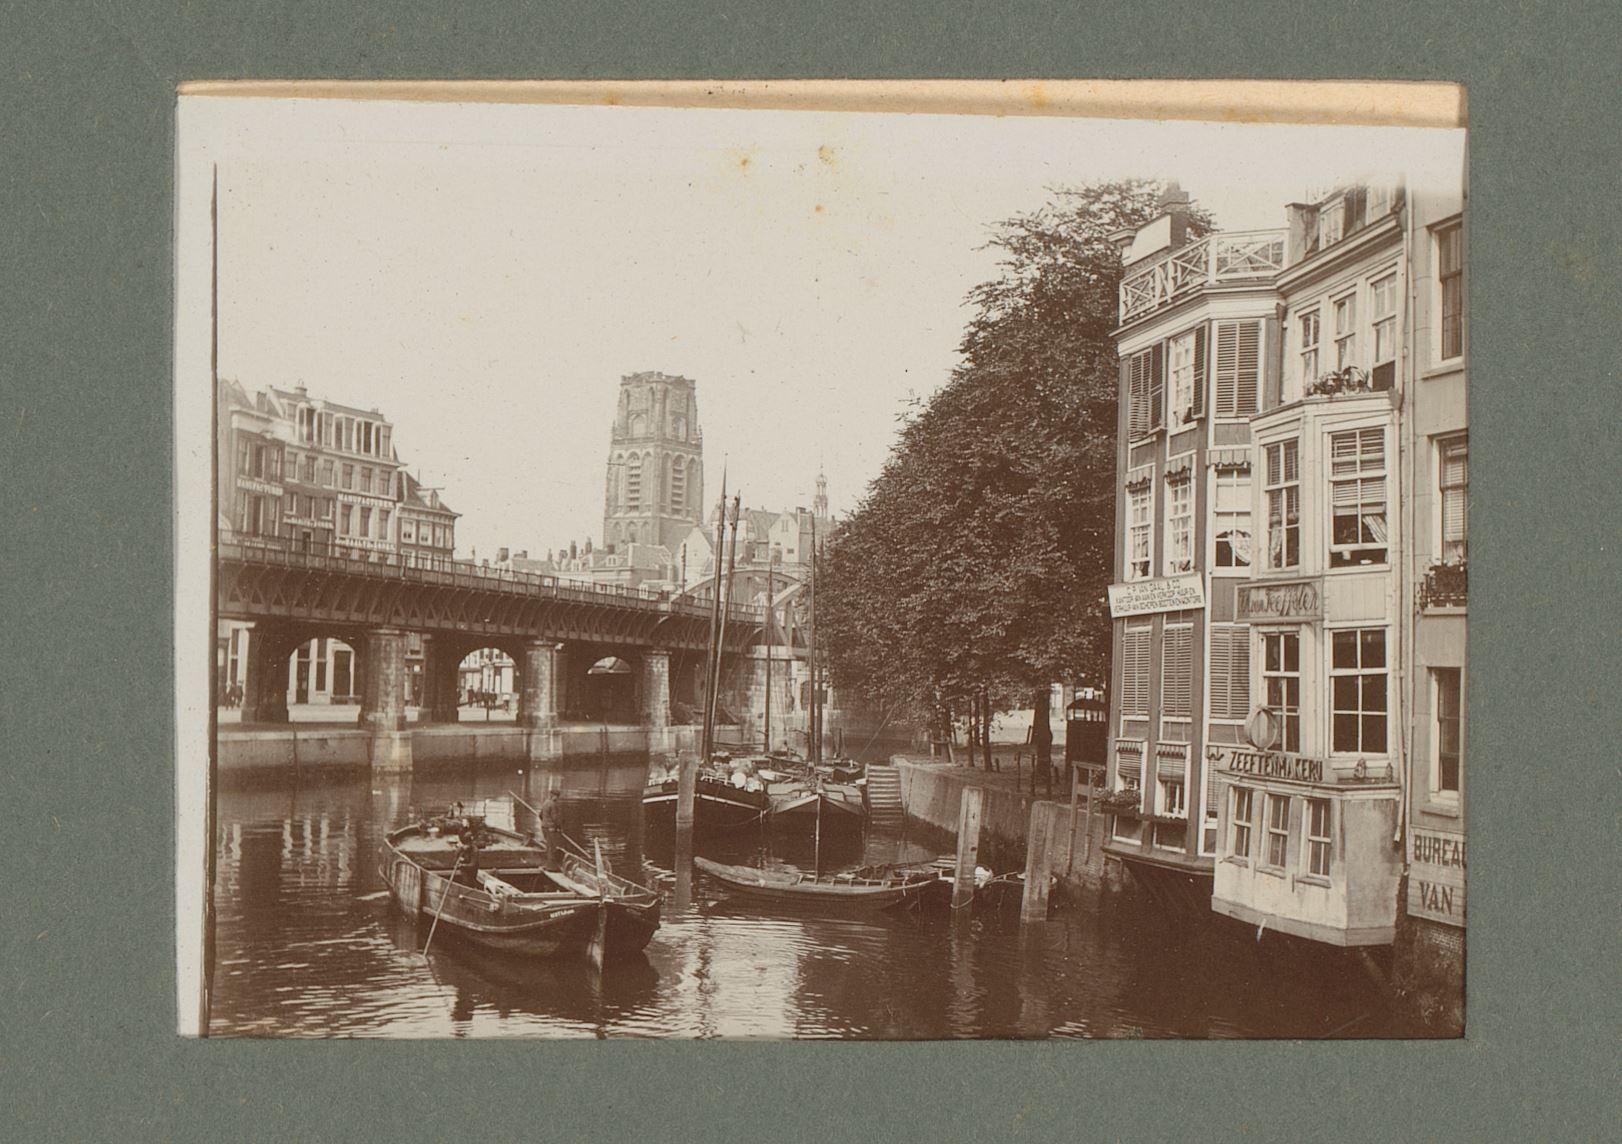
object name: album leaf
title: Gezicht op de Toerijstuin richting de Grote of Sint-Laurenskerk te Rotterdam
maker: george hidderley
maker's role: fotograaf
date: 1900-1920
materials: photographic support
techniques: gelatin silver print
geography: rotterdam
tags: bailey bridge, canals, waters (in city), parts of church exterior and annexes: tower